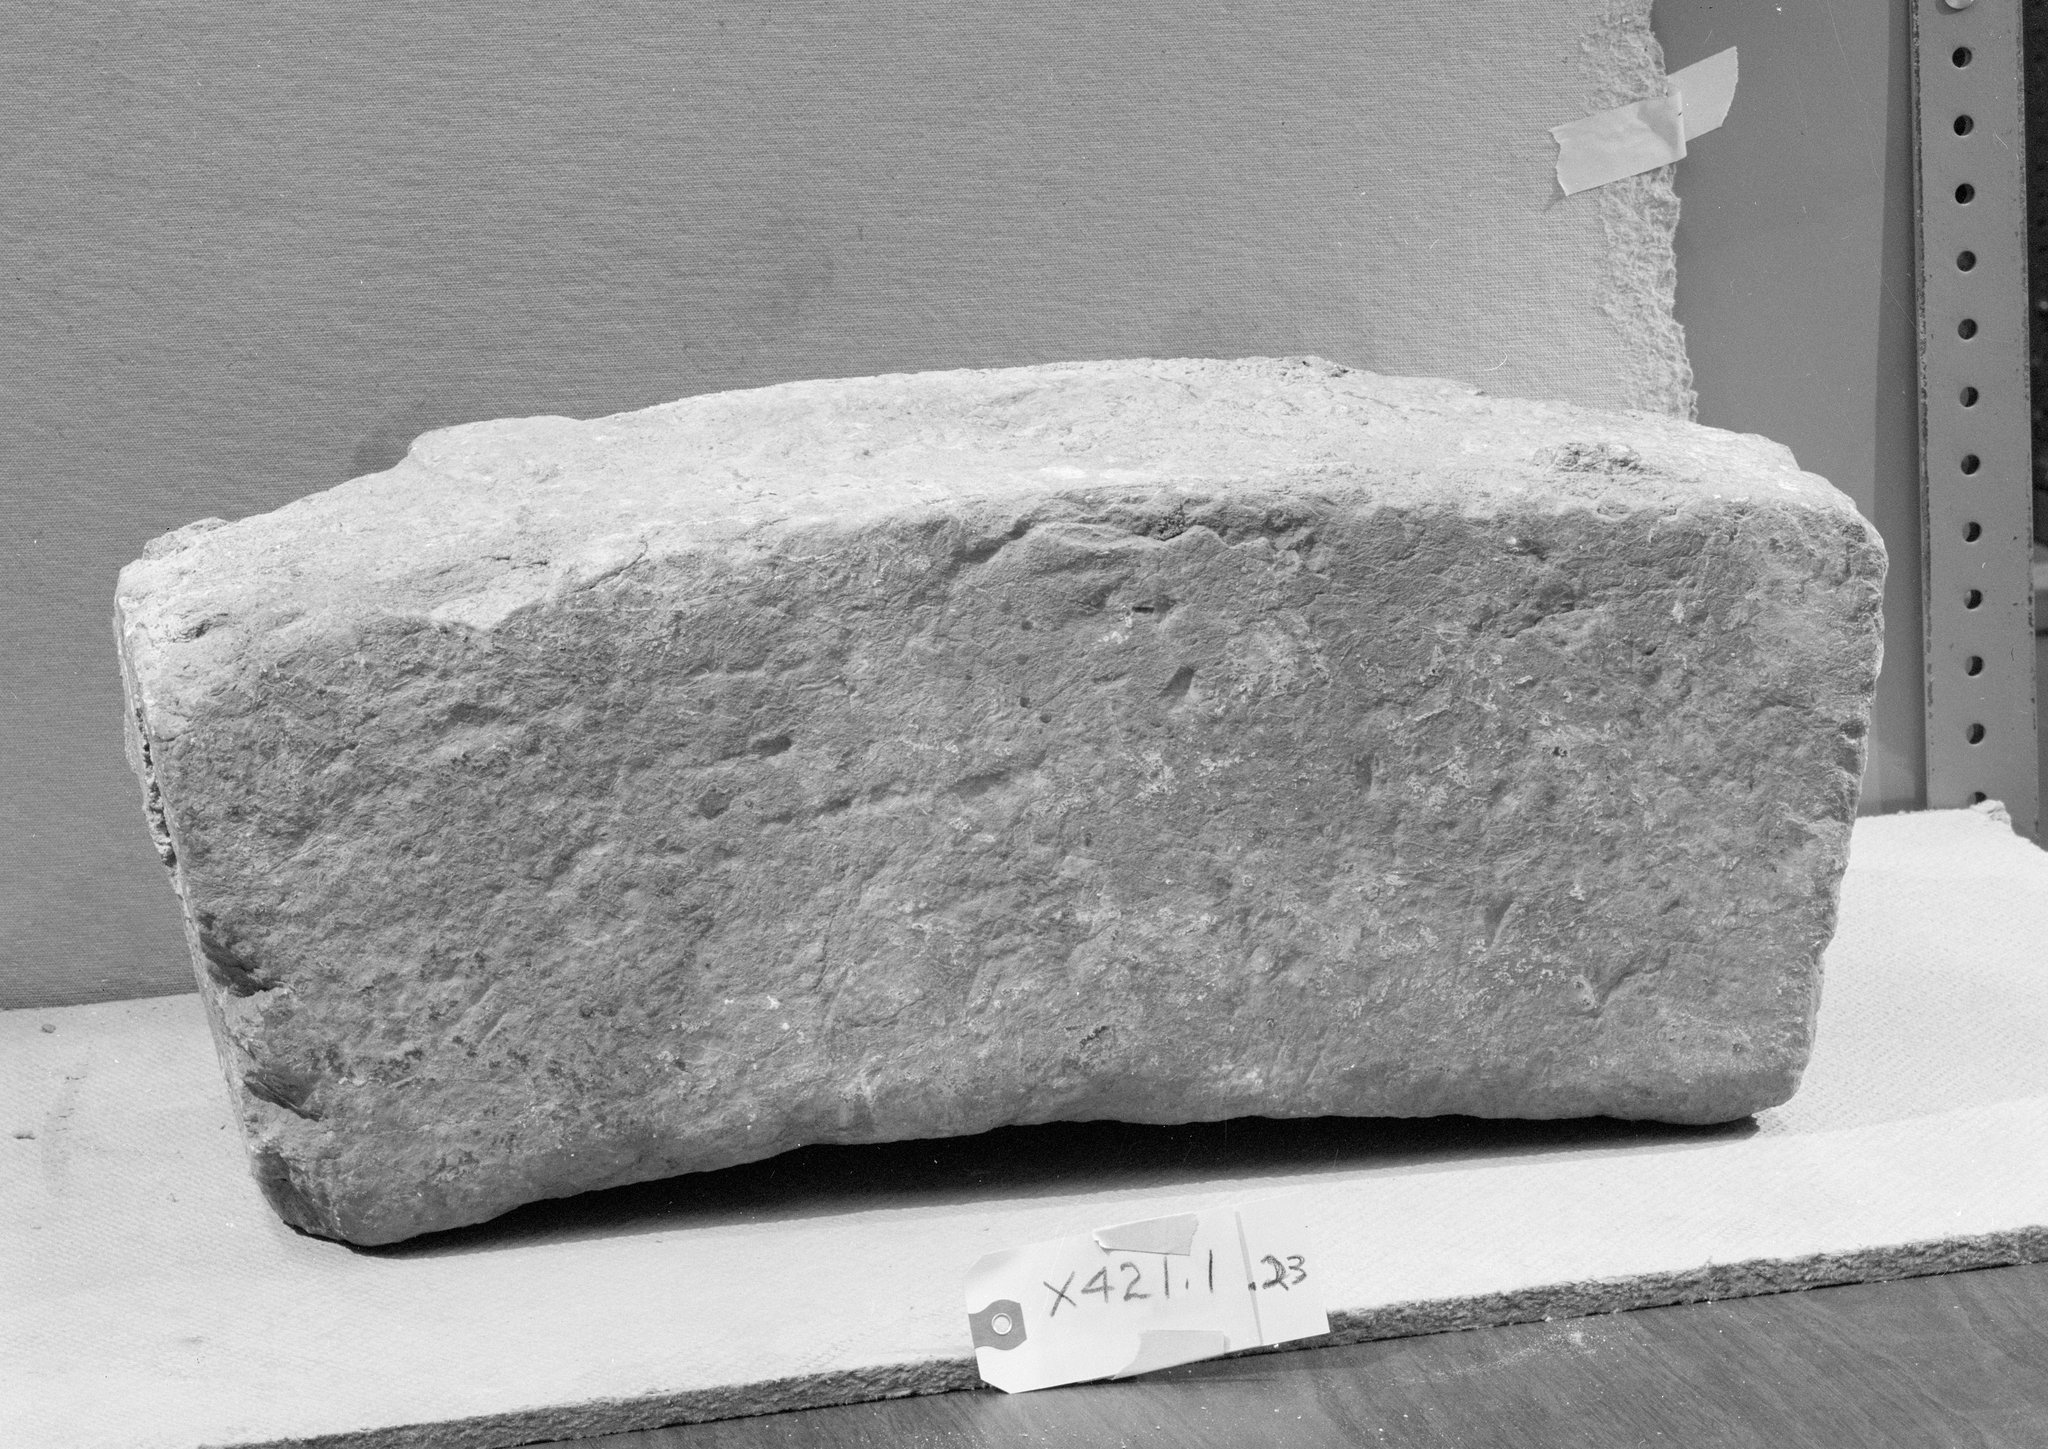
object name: voussoir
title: Voussoir Section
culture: french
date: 1130-1140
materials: stone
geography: france